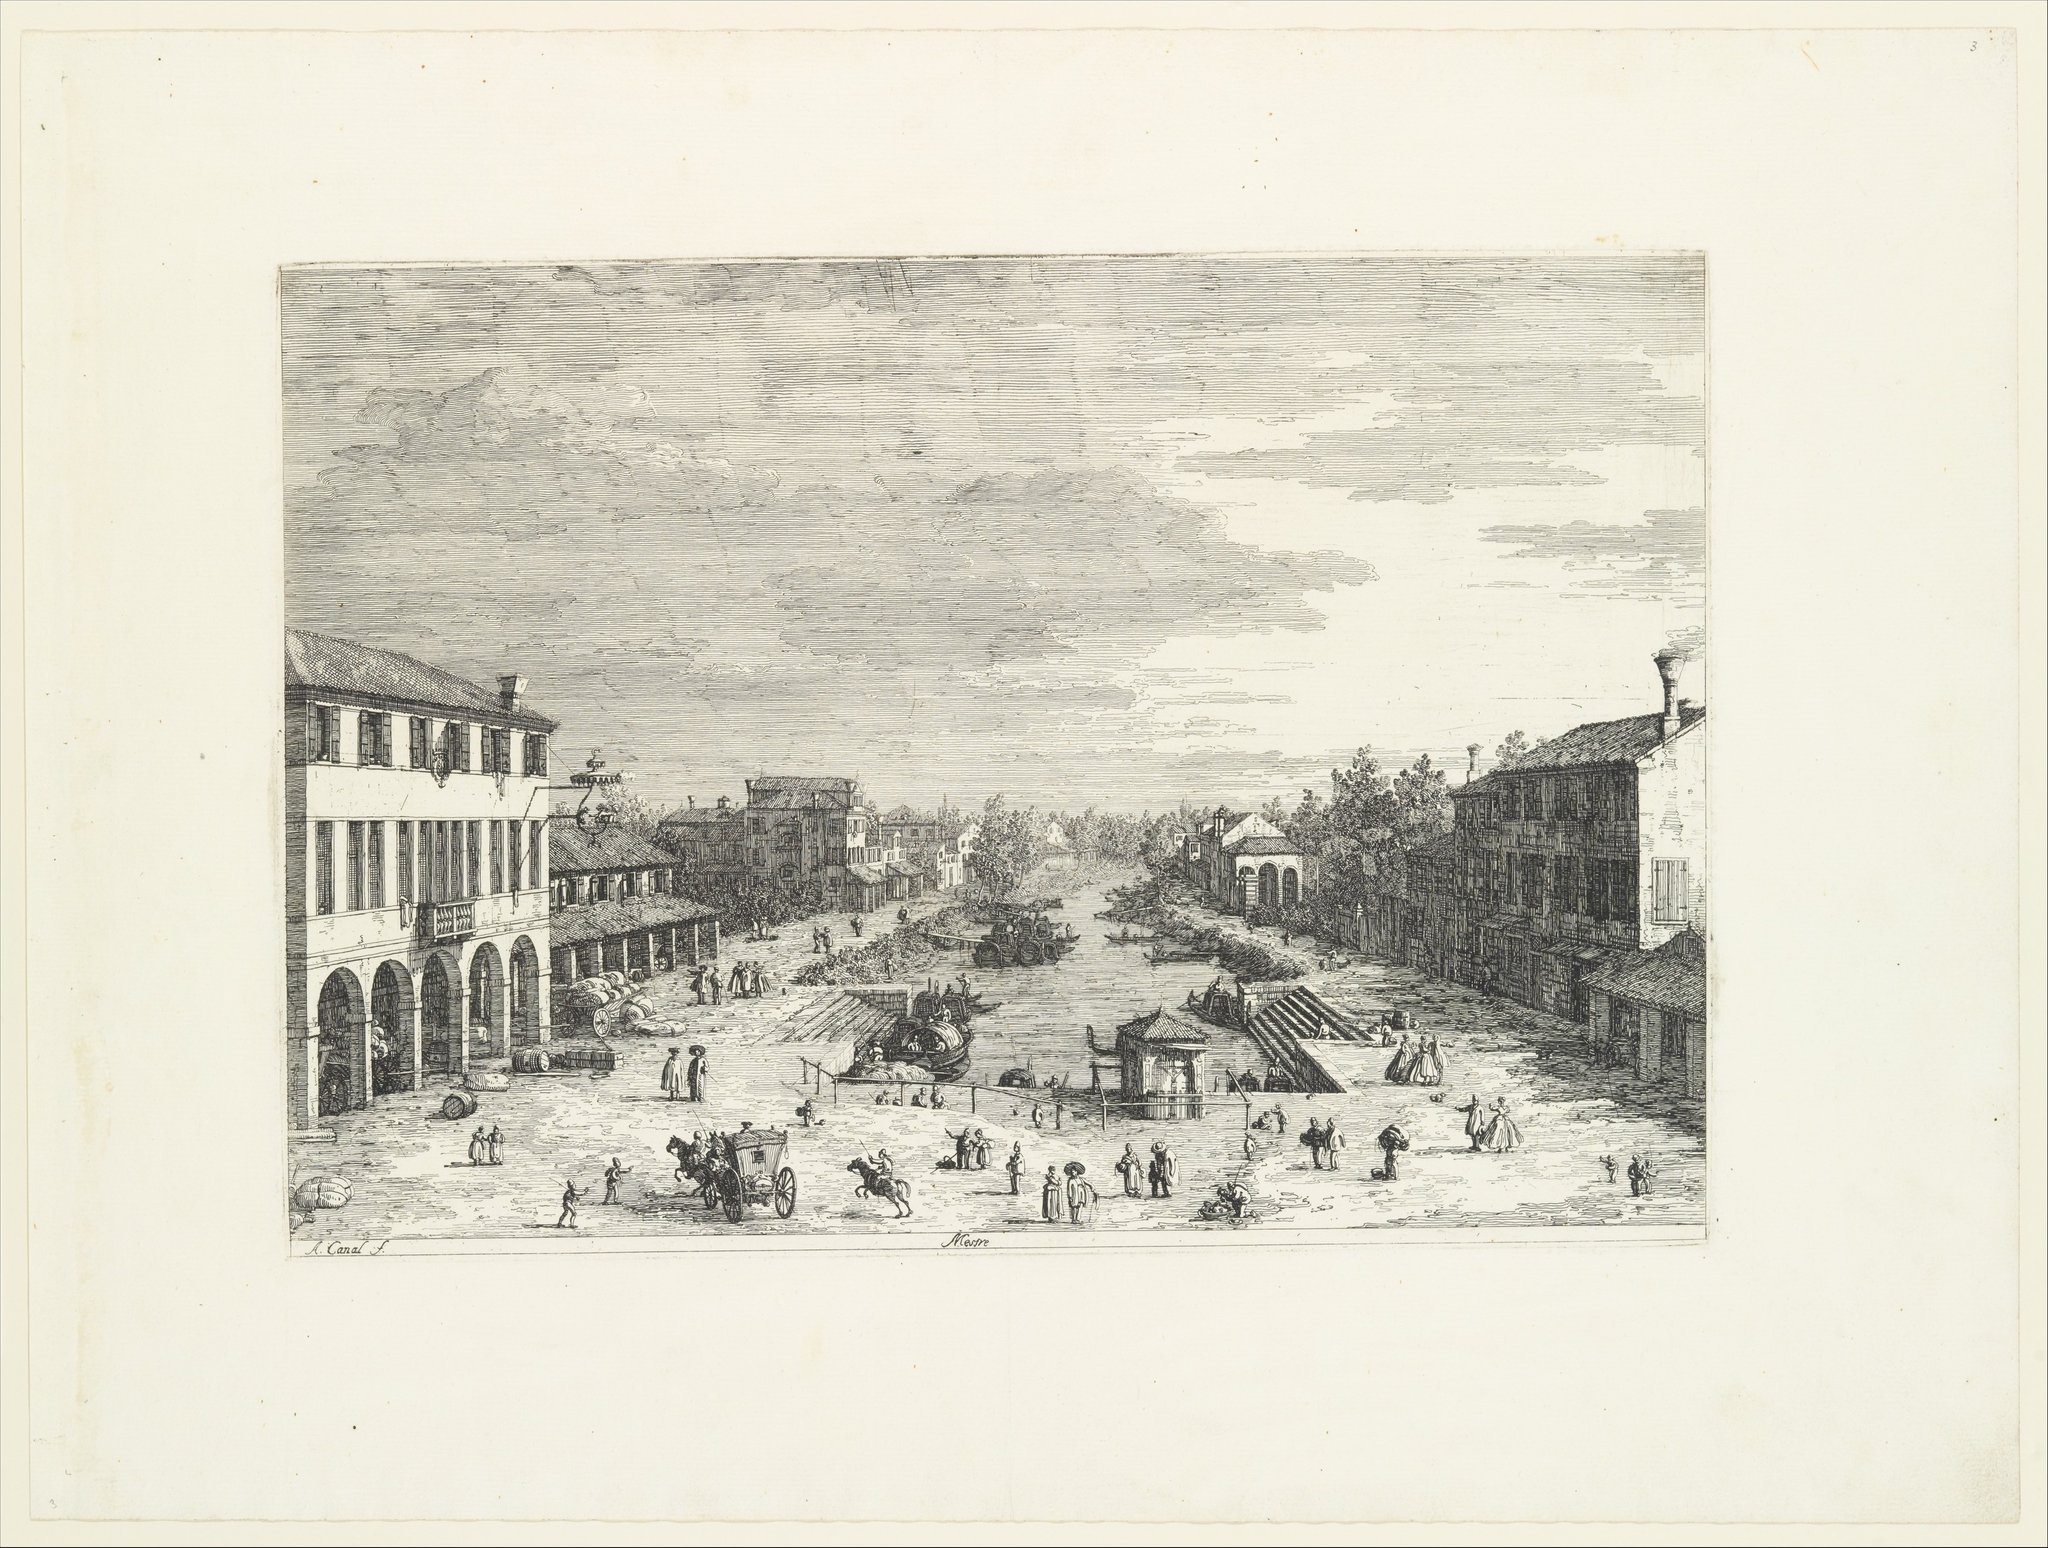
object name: print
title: View of Mestre, an inn at left and other various buildings lining the canal, from "Views" (Vedute altre prese da i luoghi altre ideate da Antonio Canal)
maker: canaletto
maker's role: artist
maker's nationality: italian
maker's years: 1697-1768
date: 1735-1746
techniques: etching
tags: human figures,buildings,canals,boats